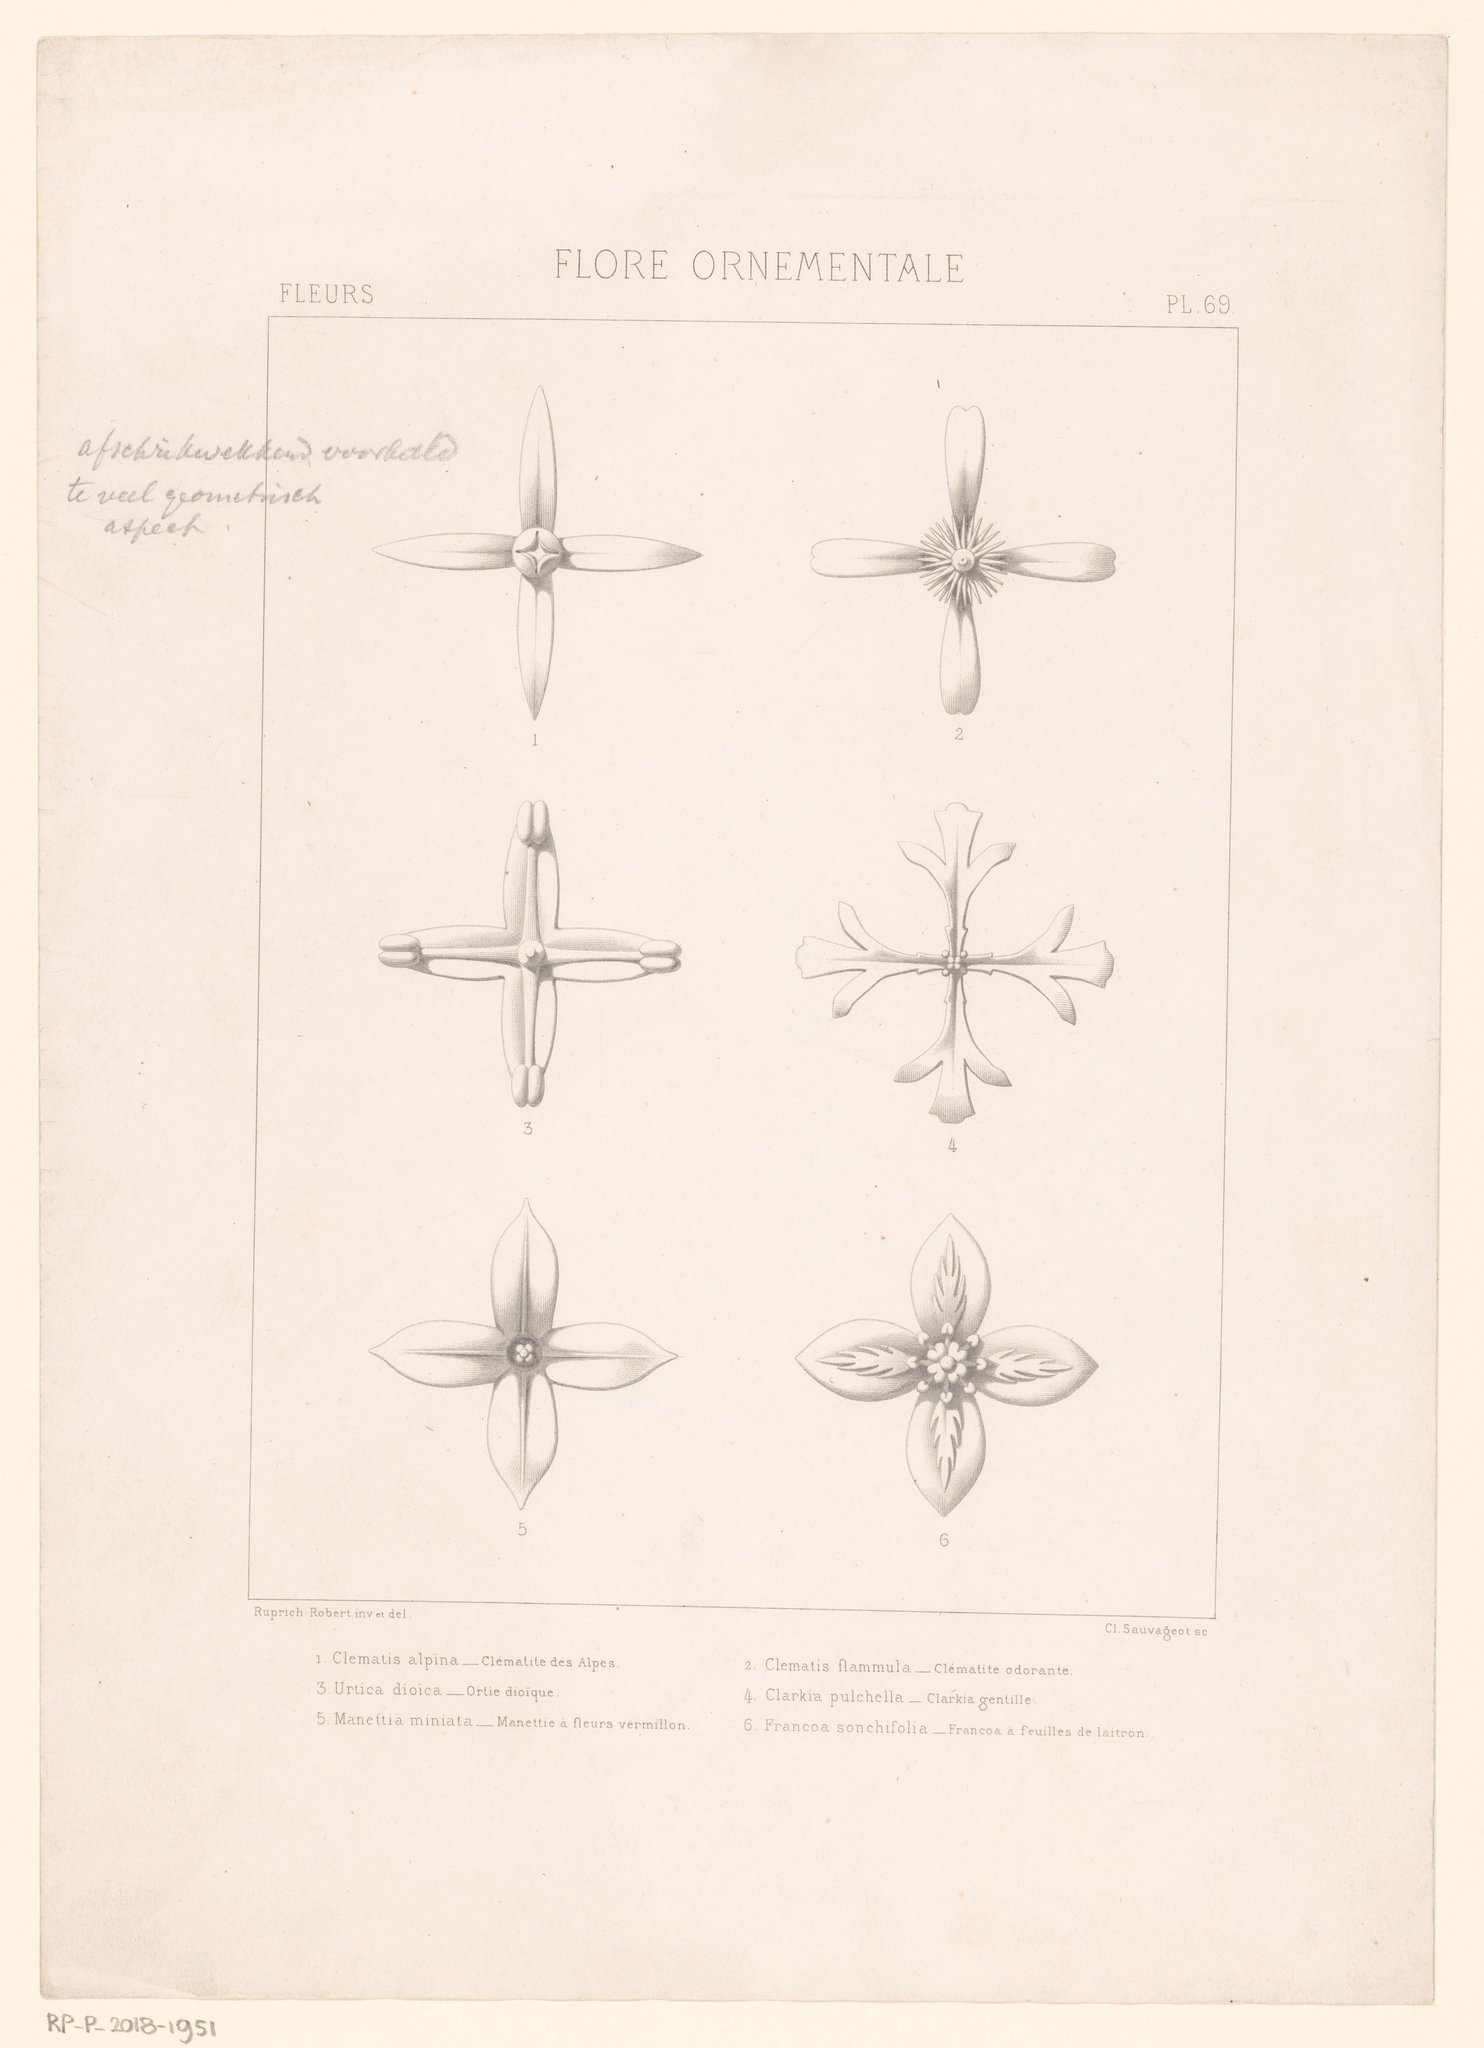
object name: print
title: Studieblad met vooraanzichten van verschillende bloemen met vier bladeren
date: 1842-1885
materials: paper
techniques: engraving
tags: model-books ~ implements of painter, flowers ~ ornament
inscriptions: collector's mark: Lugt 3937, collector's mark: Lugt 2228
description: Prent uit: Ruprich-Robert, Victor. Flore ornementale : essai sur la composition de l'ornement : éléments tirés de la nature et principes de leur application. Parijs: Dunod, 1876, nr. 69.